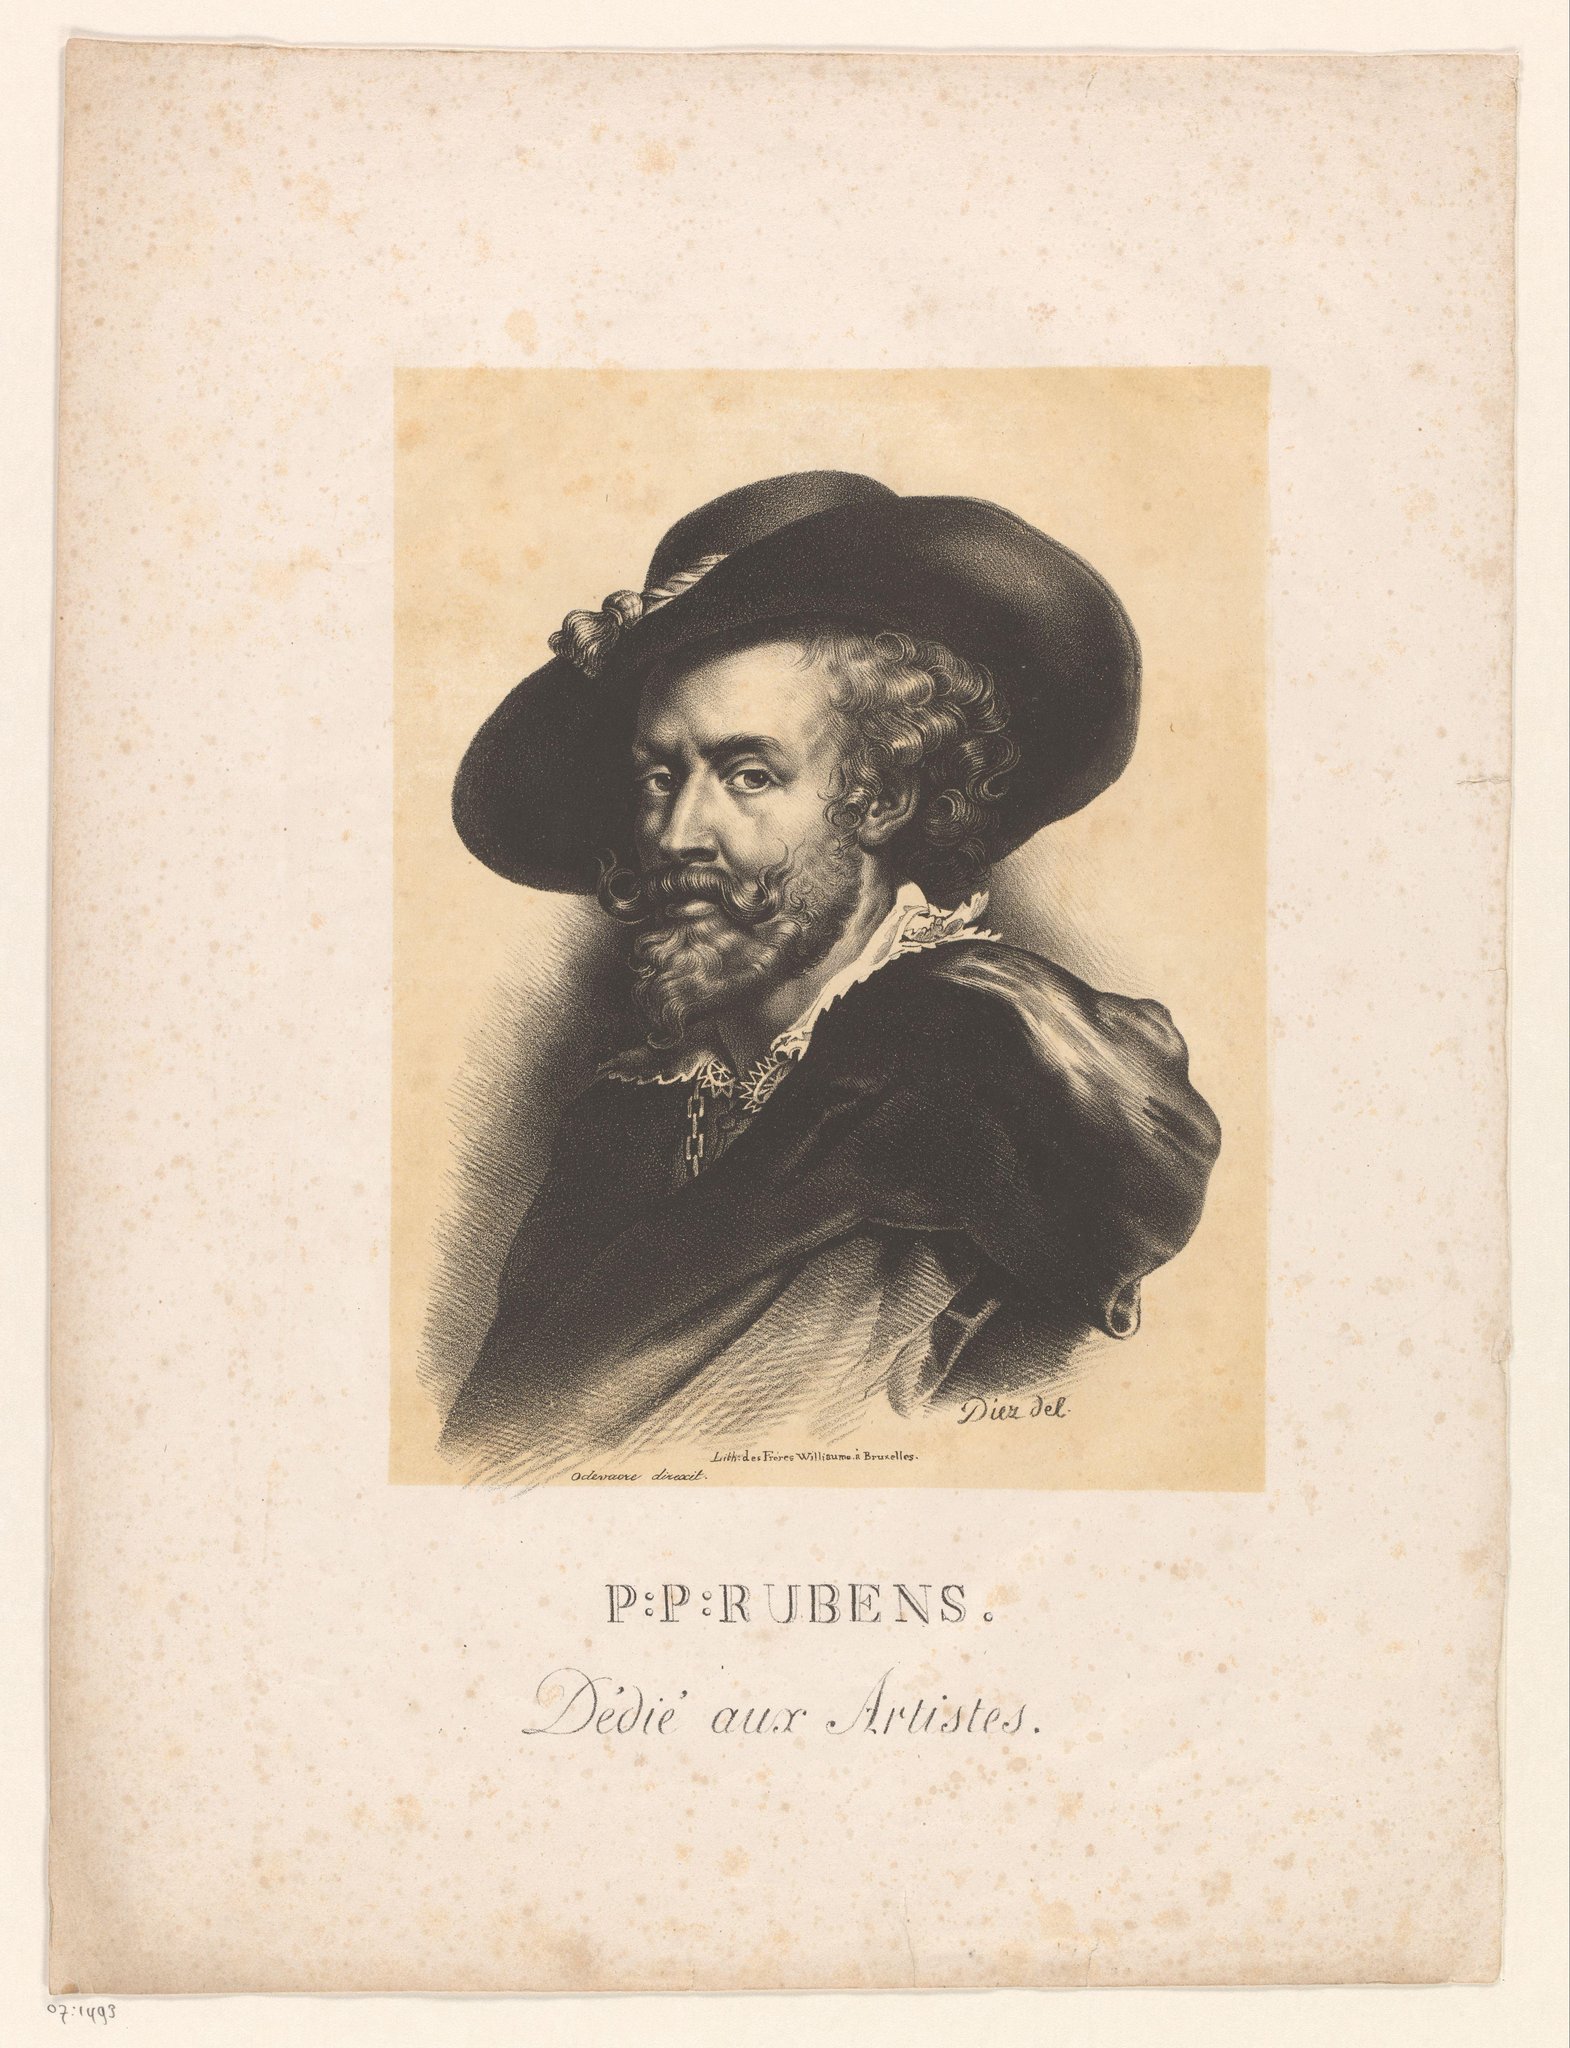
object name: print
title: Portret van Peter Paul Rubens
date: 1820-1830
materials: paper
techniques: tone lithography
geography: brussels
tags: antwerp, painter, print maker, draughtsman, peter paul rubens, head-gear, adult man, historical persons, beard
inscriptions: collector's mark: Lugt 2228